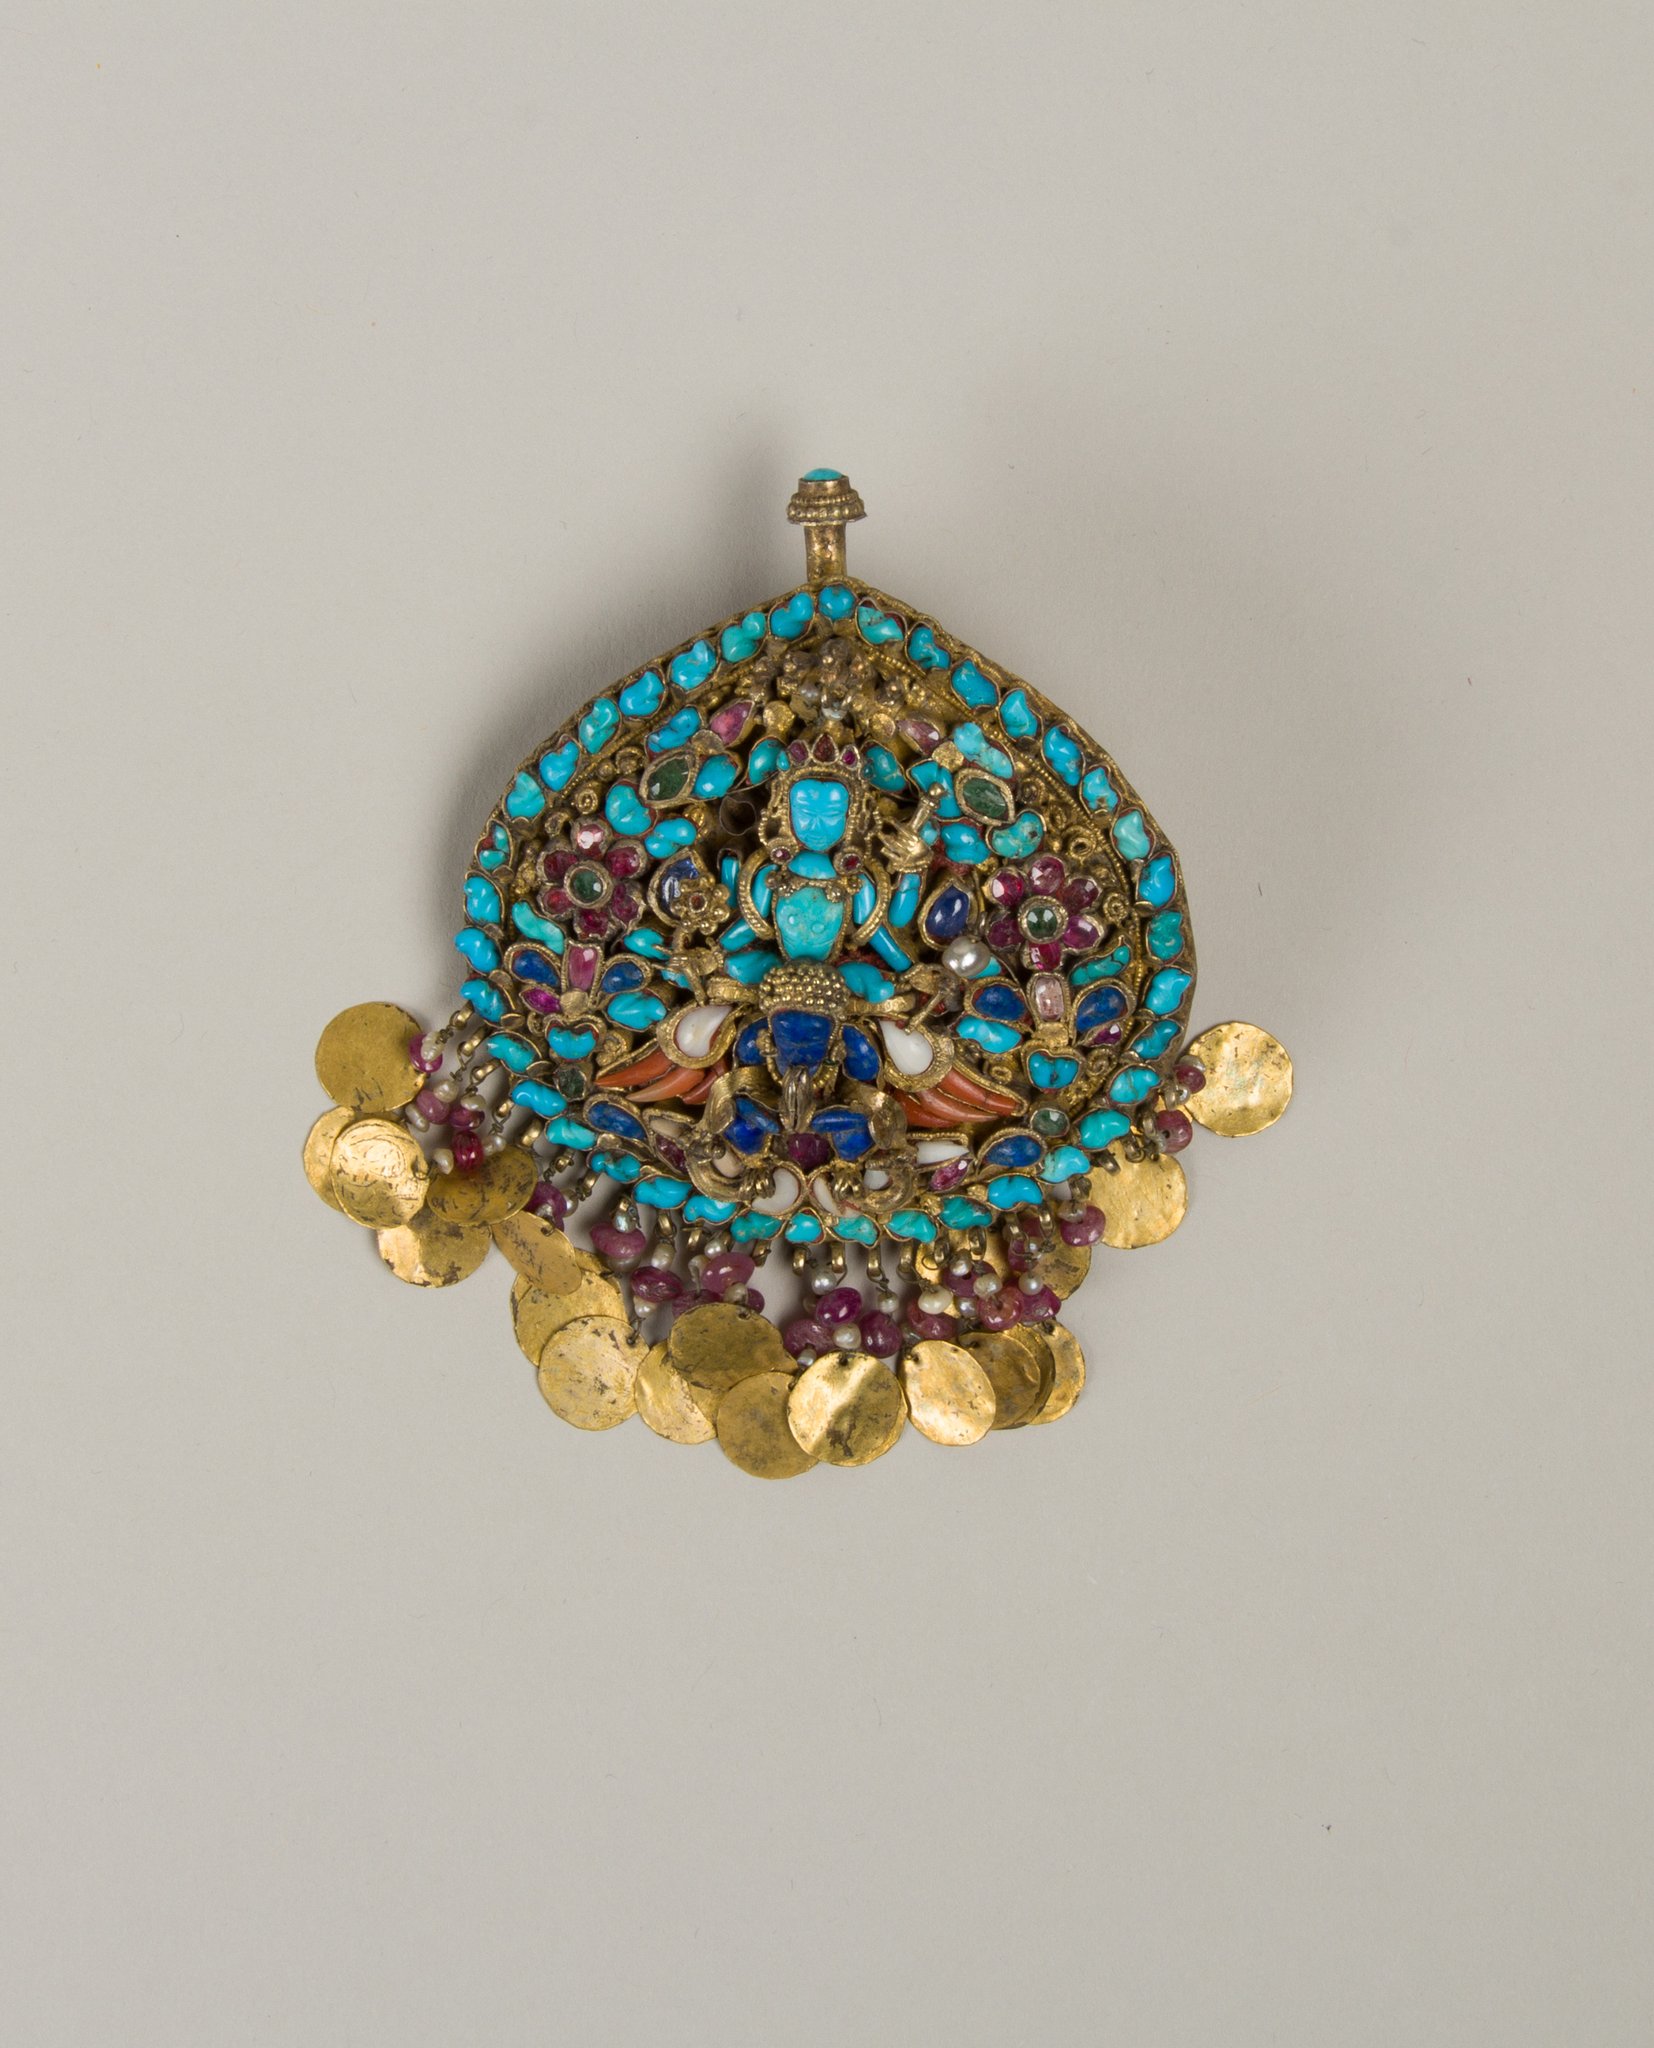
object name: ornament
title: Earring for a Deity Showing Vishnu Riding Garuda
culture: nepali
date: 1601-1900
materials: coral, silver gilt, lapis lazuli, pearl, gemstone, shell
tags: vishnu